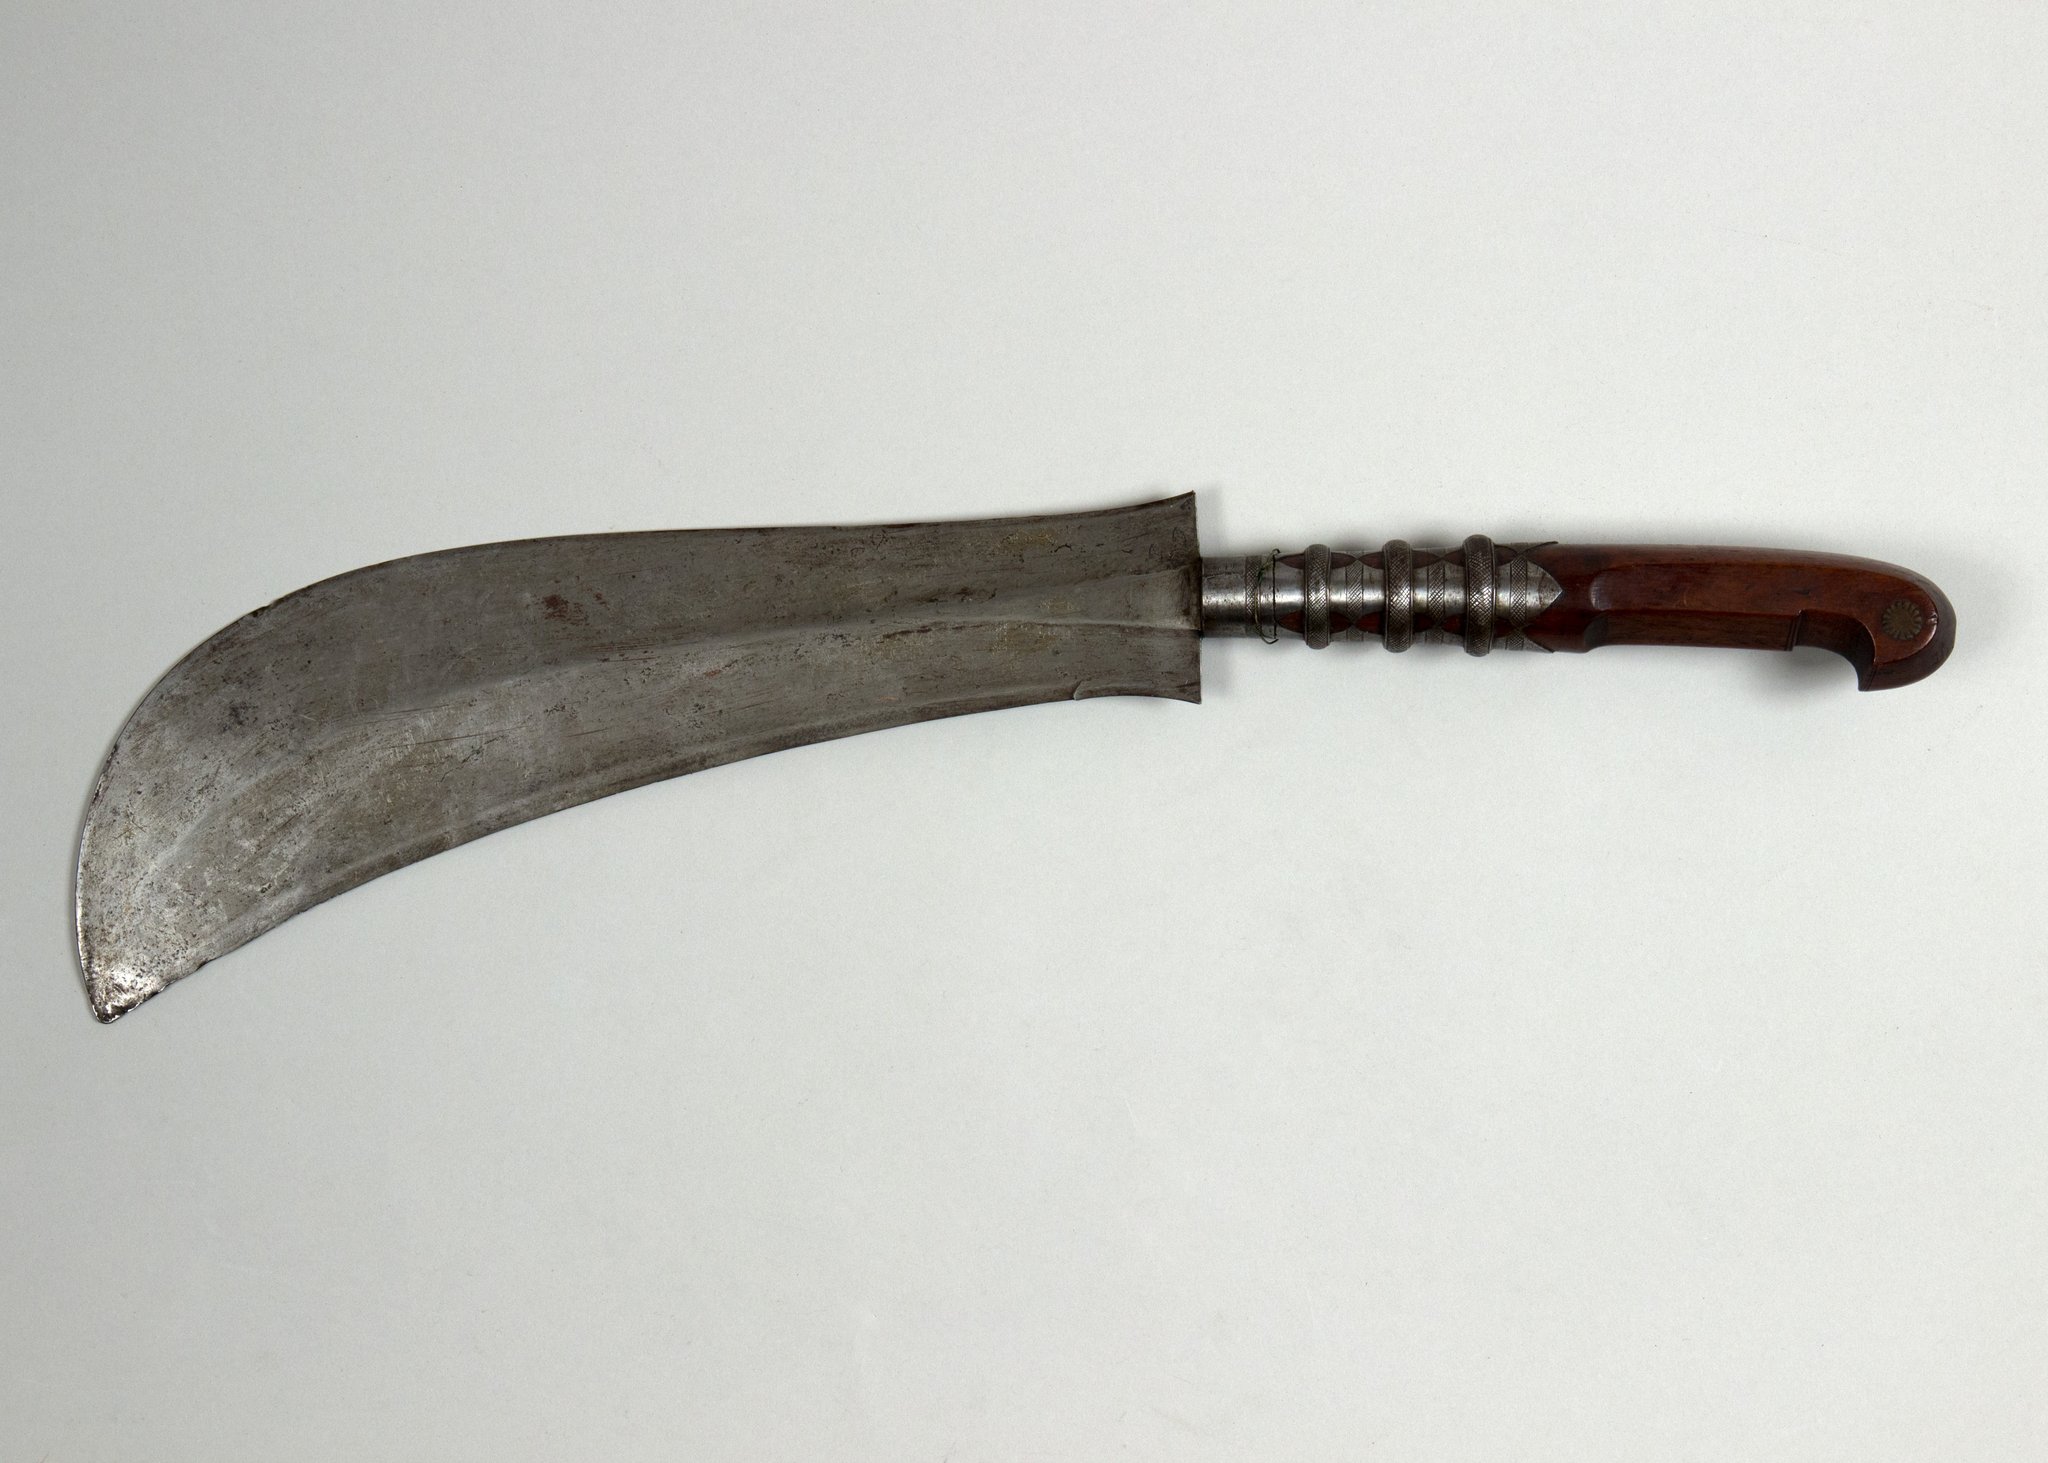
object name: moplah knife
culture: indian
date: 1701-1900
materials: brass, silver, steel, wood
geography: india